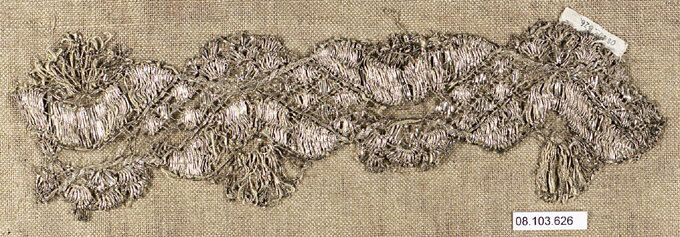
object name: piece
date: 1701-1800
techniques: lace